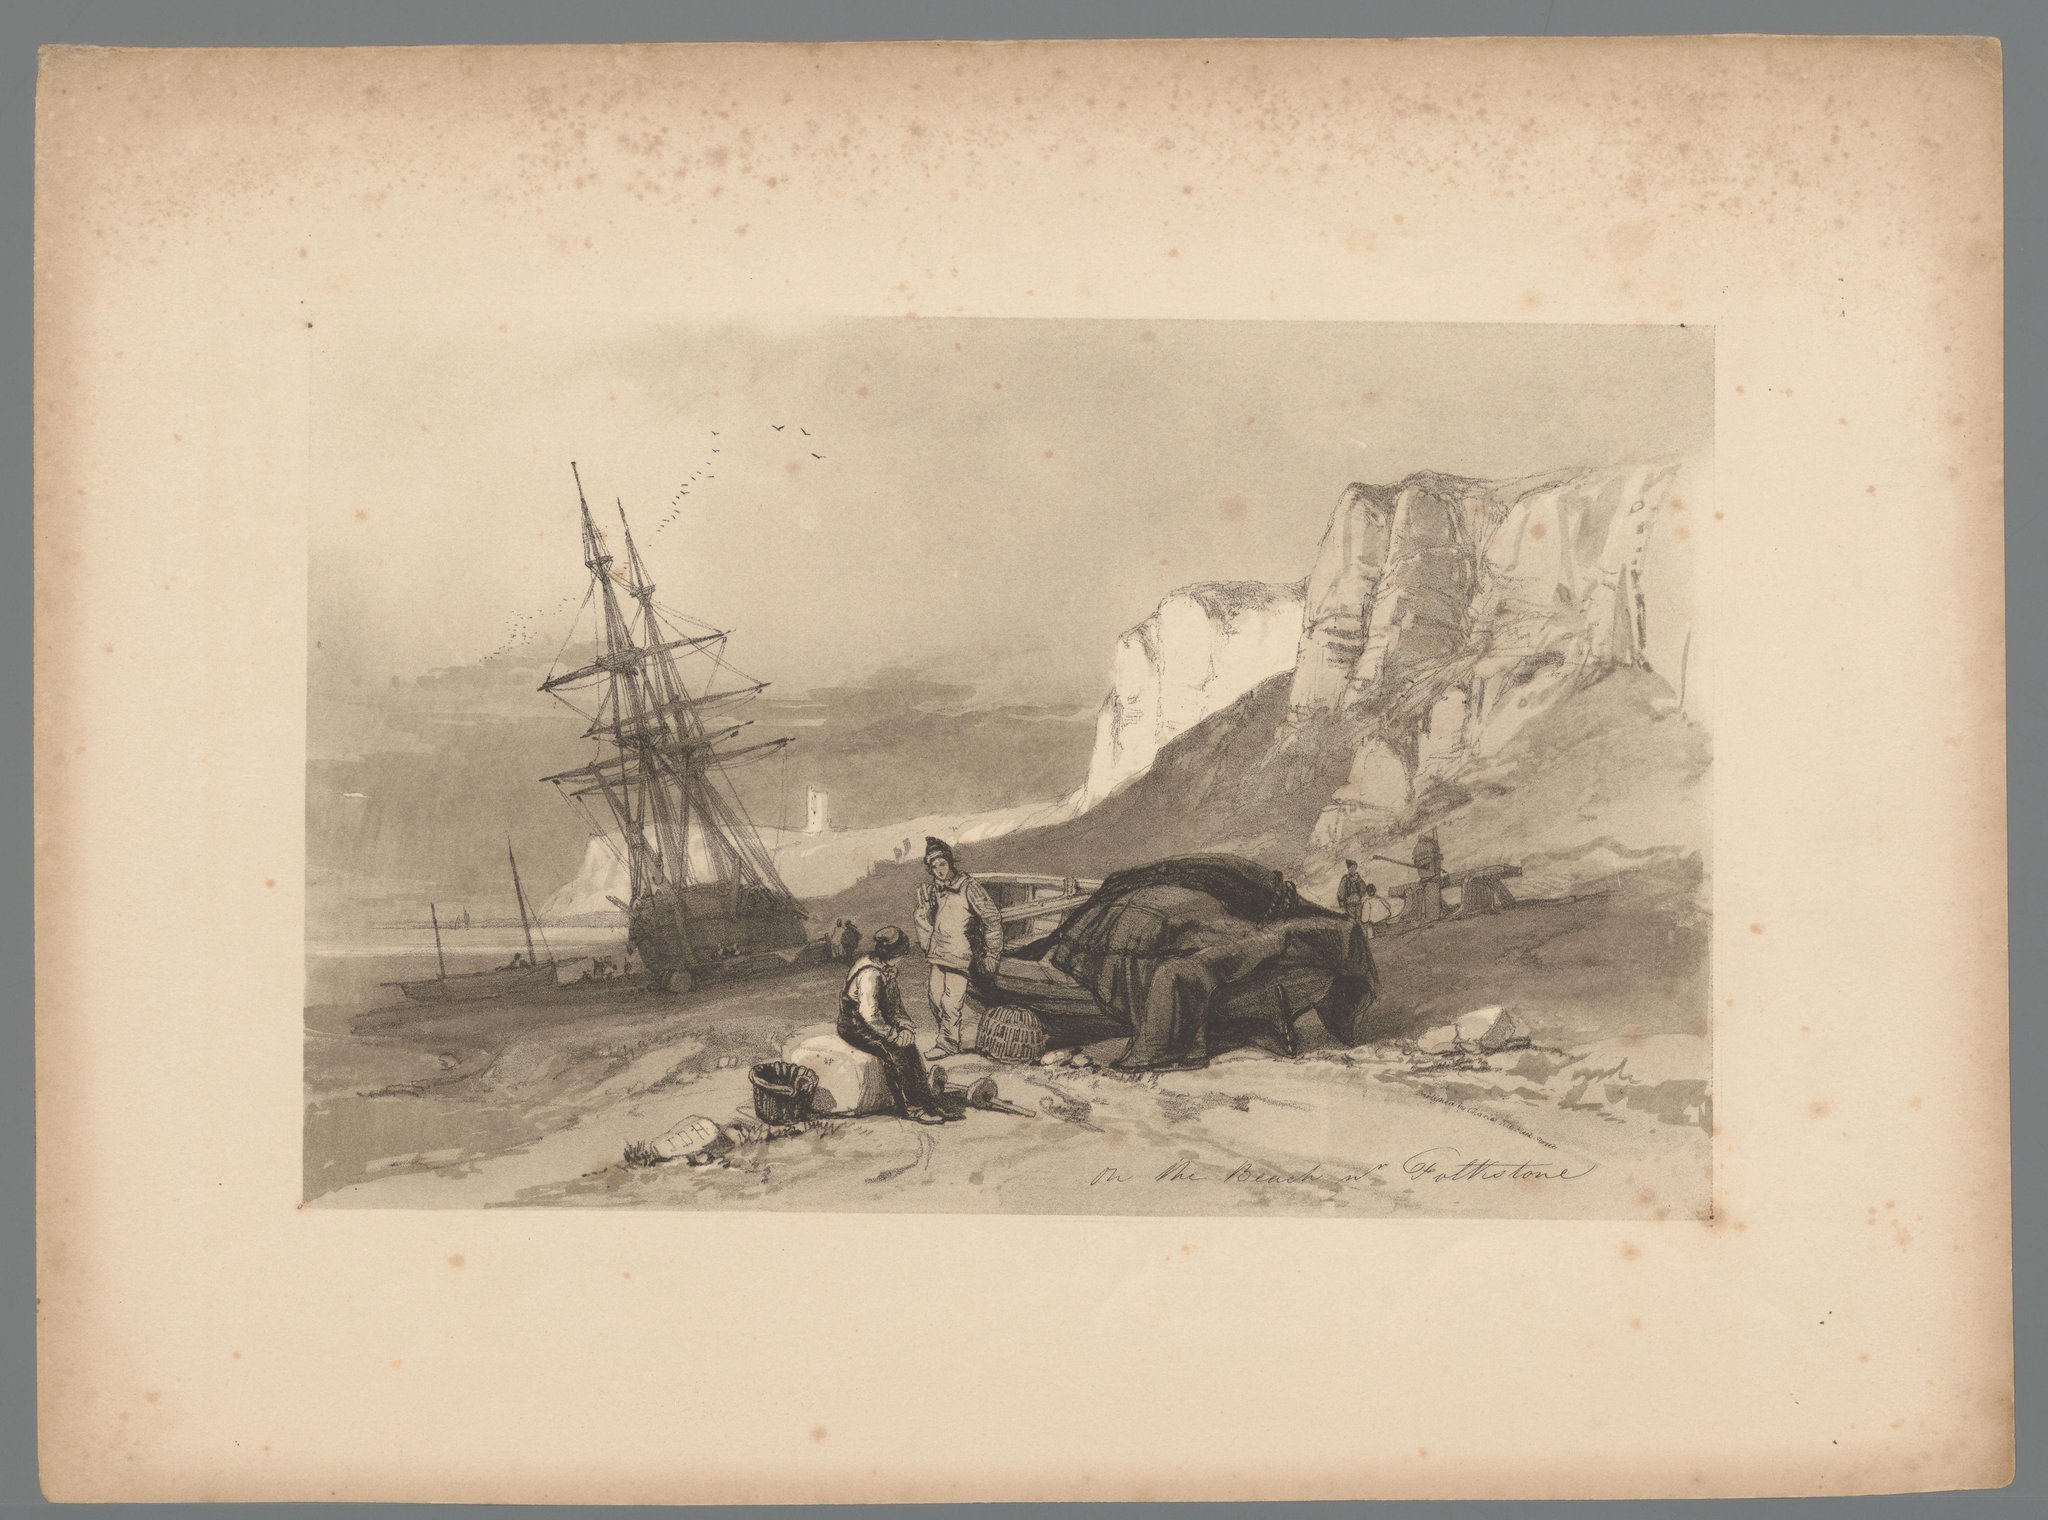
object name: print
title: Kustlandschap met twee figuren bij een boot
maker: james duffield harding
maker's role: draughtsman, painter, print maker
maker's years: 1798-1863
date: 1841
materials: paper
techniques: tone lithography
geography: london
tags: ships, boats on land, beached, coast (+ landscape with figures, staffage)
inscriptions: collector's mark: Lugt 2228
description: Uitgever Charles Tilt (met Bogue) heeft verschillende series uitgegeven over het werk van James Duffield Harding. Deze serie 'Harding's drawing book, for the year MDCCCXLI', bestaat uit zes delen.